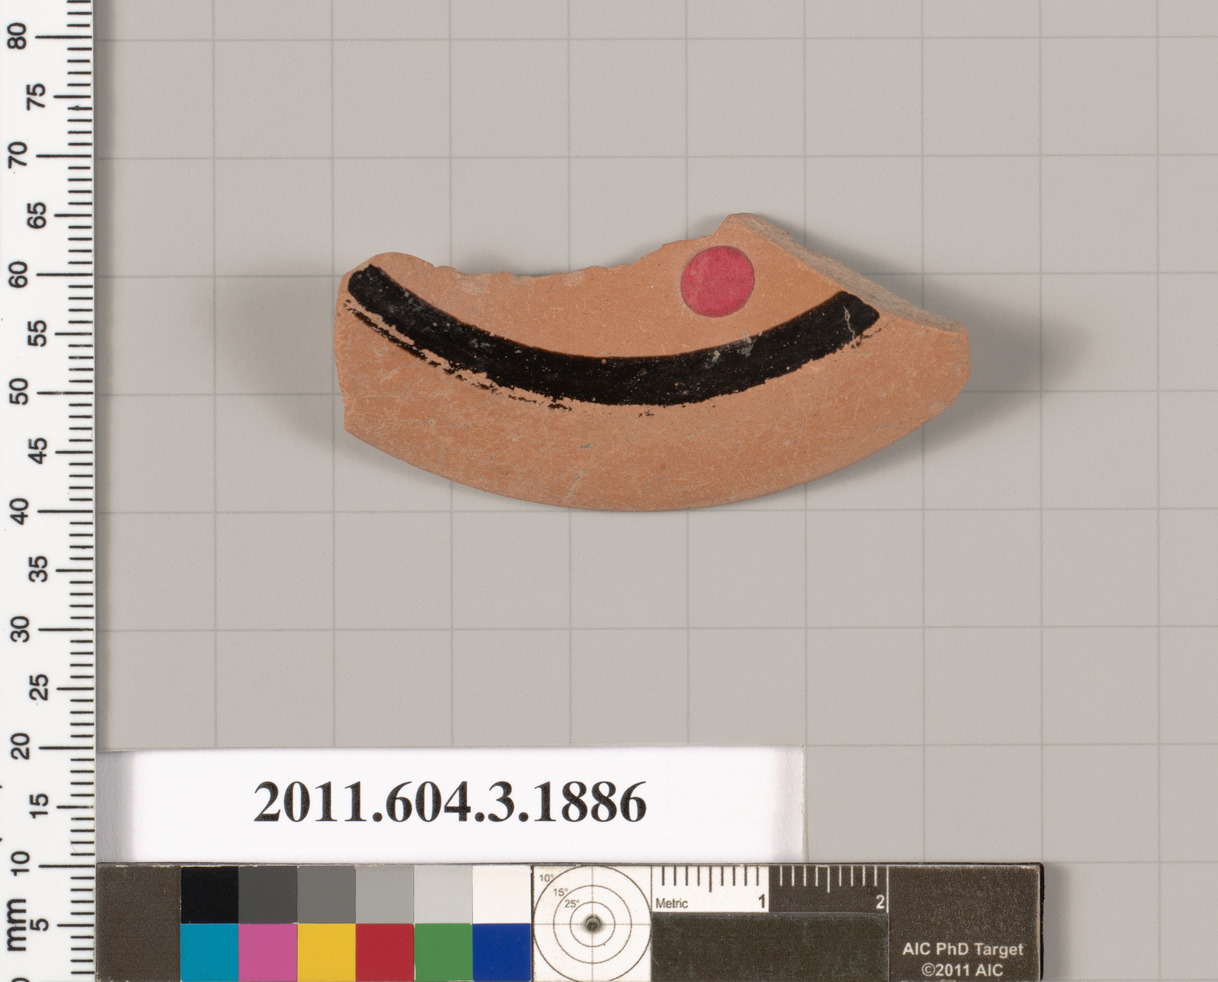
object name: kylix fragment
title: Terracotta fragment of a kylix (drinking cup)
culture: greek, attic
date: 600-401 BCE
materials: terracotta